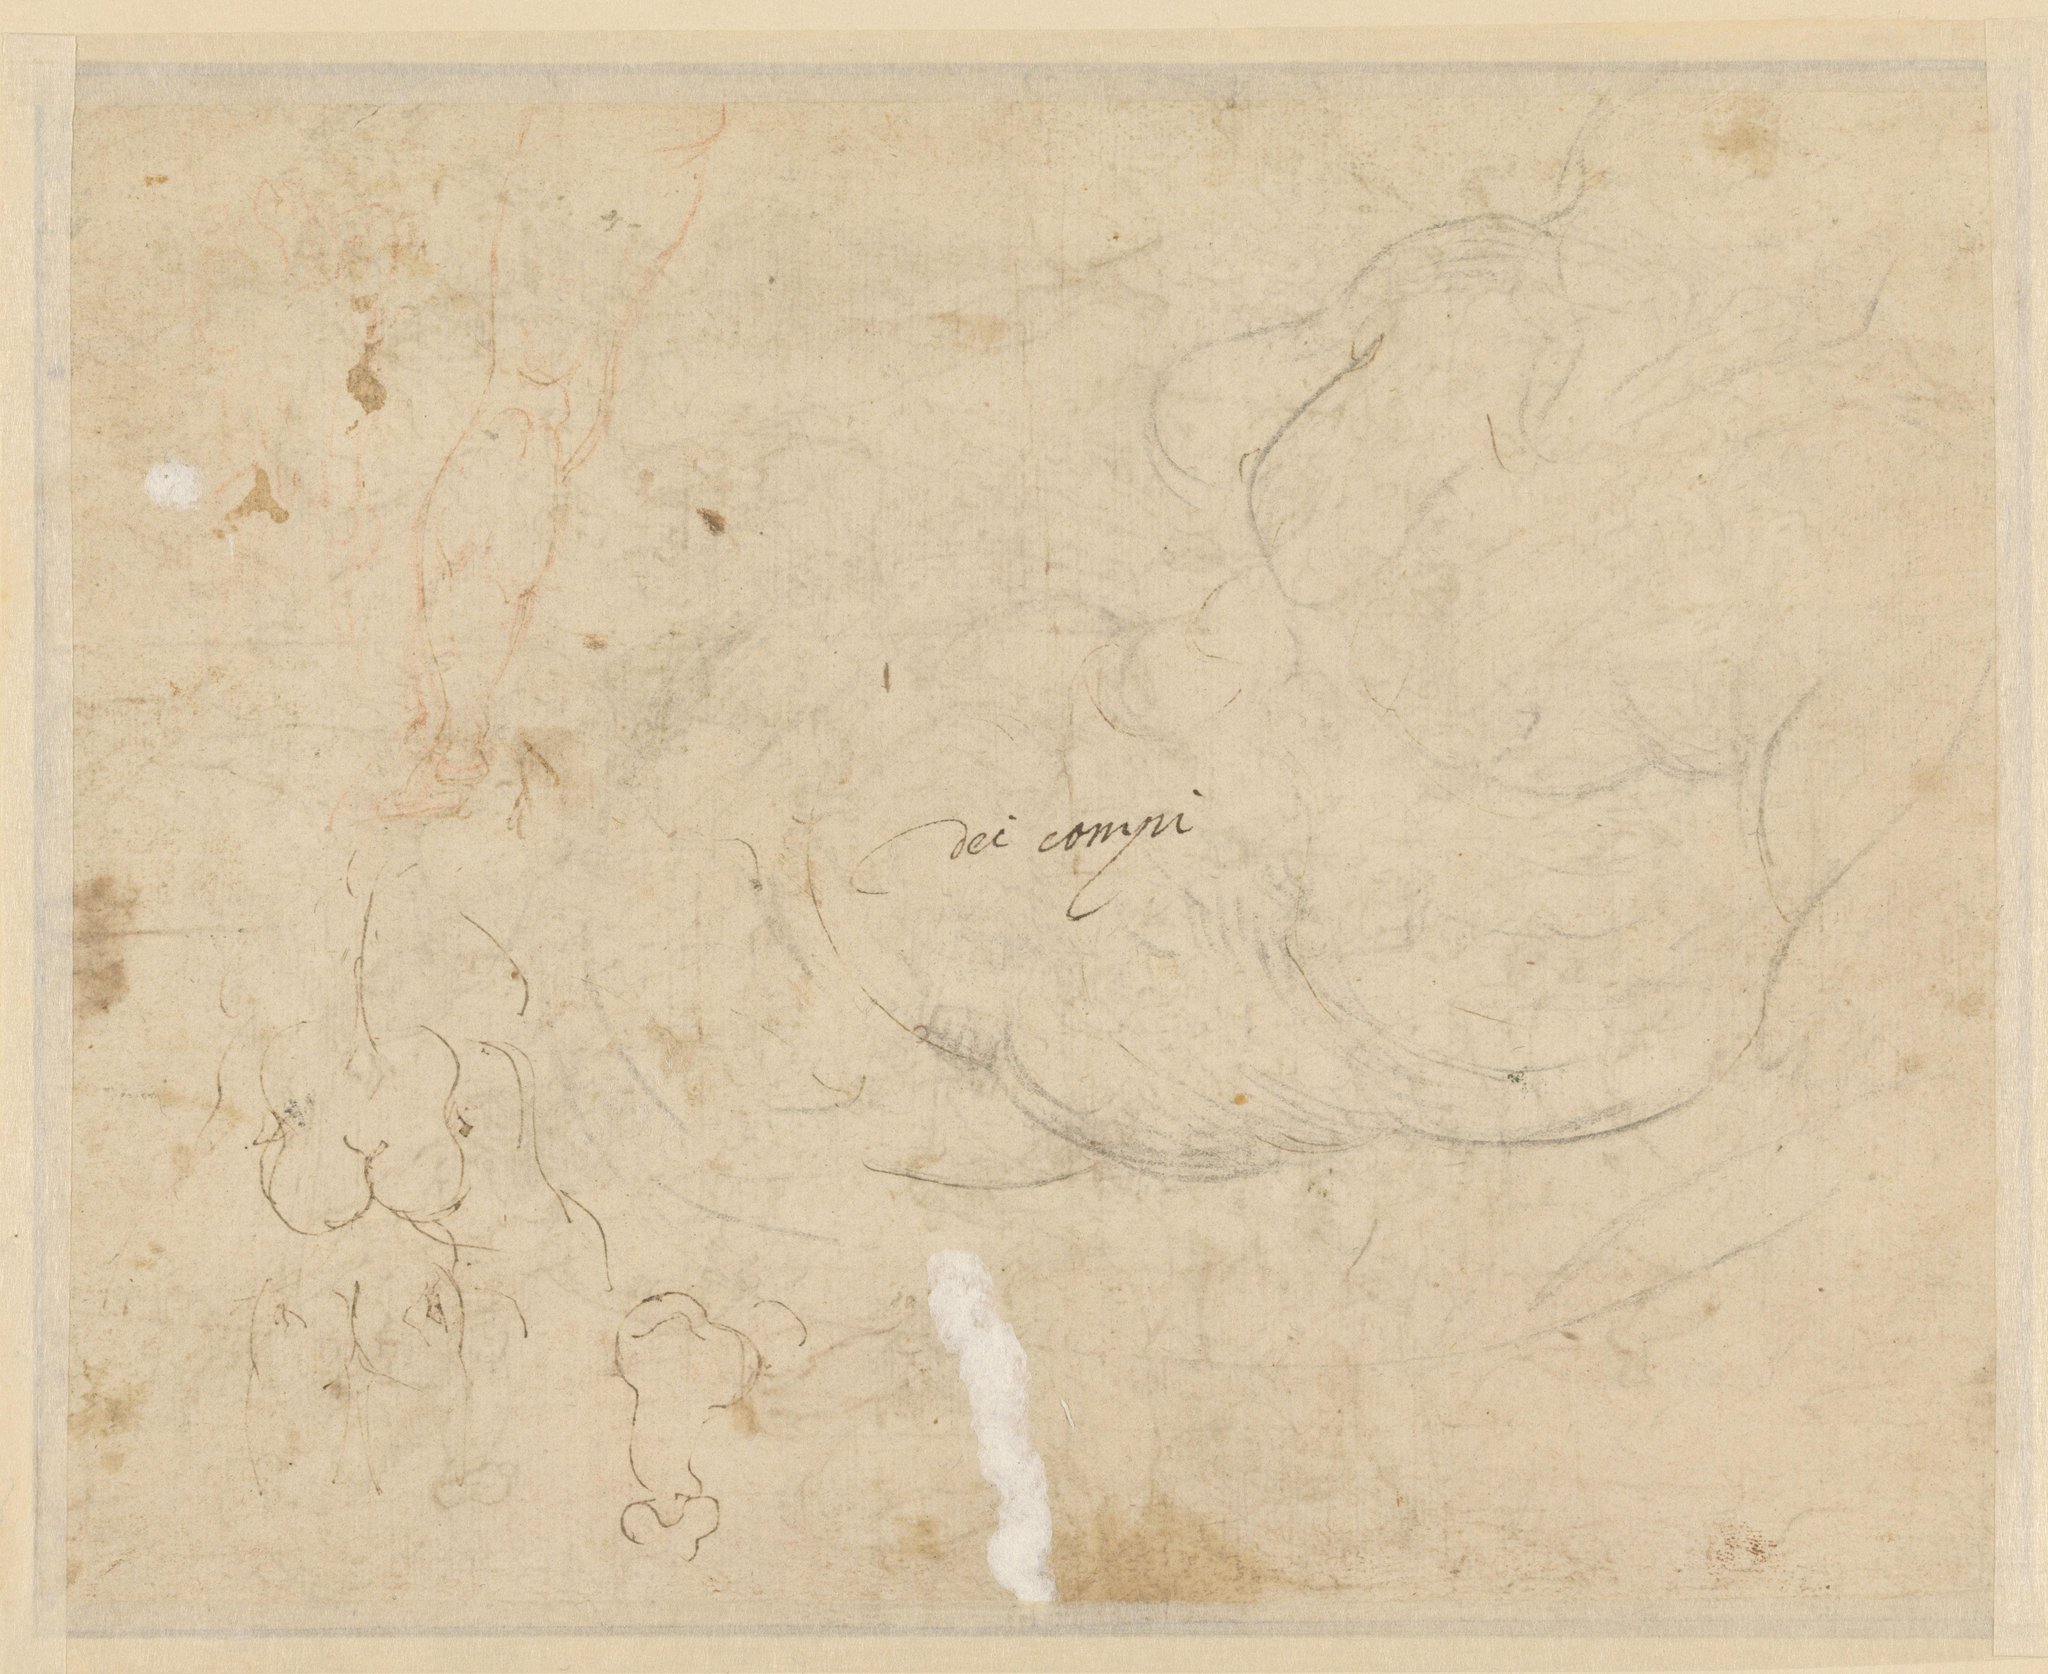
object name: drawing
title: Figuurstudies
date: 1500-1600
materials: chalk, ink, paper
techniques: pen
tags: the (nude) human figure; 'corpo humano' (ripa)